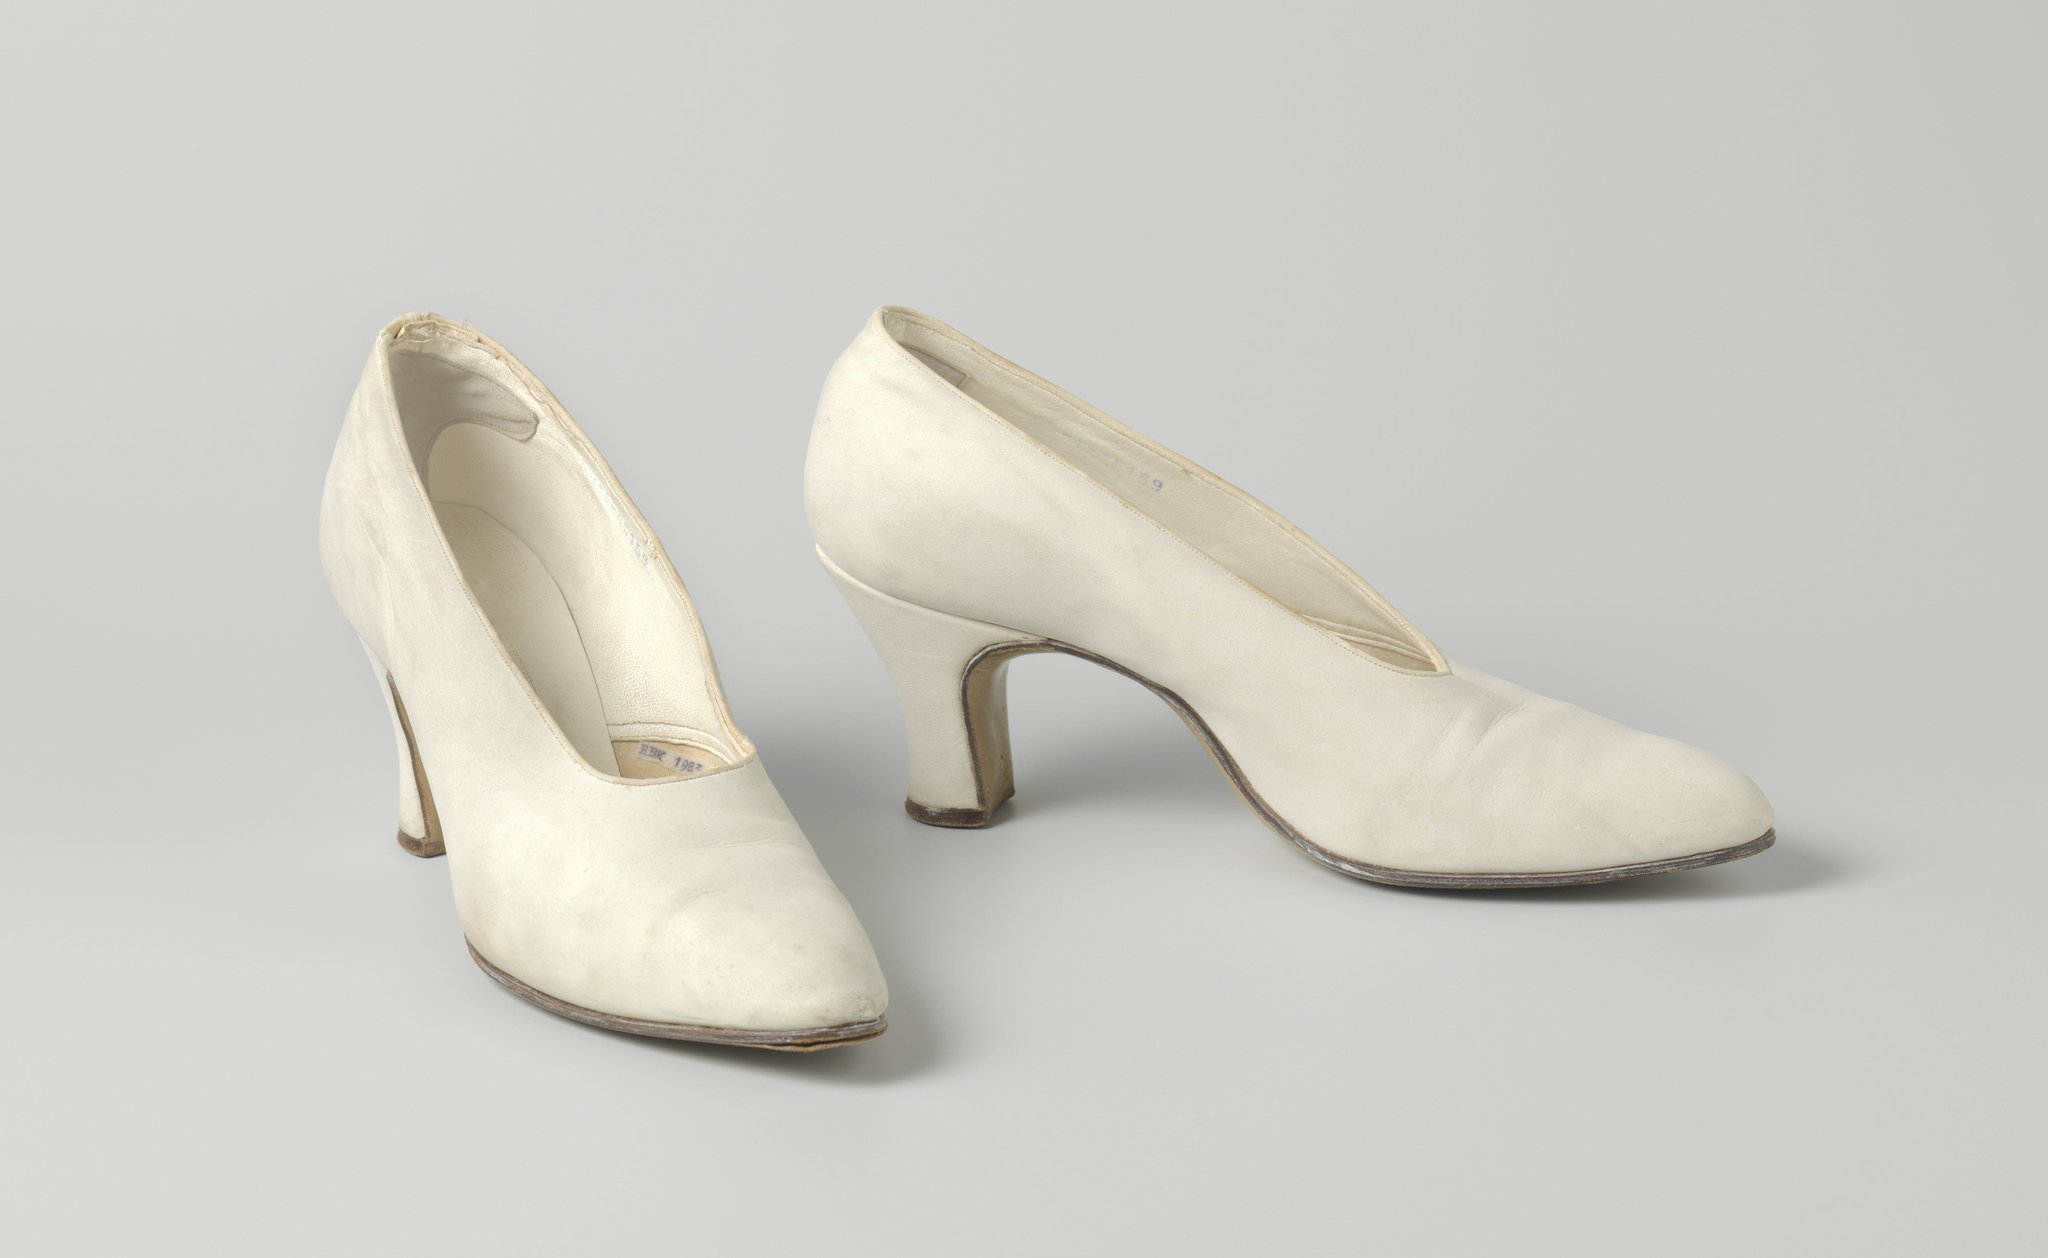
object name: damesschoen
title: Damesschoen van ivoorwit suède, hoog uitgesneden schachtrand en hoge hak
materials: leather, linen, metal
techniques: tanning, weave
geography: amsterdam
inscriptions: company name: ‘HIRSCH & Cie // AMSTERDAM’, inscription: ‘5½ - 4 - 45159’, size: ‘5½ // 4’, company name: ‘HIRSCH & Cie // AMSTERDAM’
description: Damesschoen van ivoorwit suède. Model: Spitse neus, blad uit één stuk leer. De voorkant van de hak loopt in een afgeronde hoek recht naar beneden. De zijkant en achterkant zijn iets getailleerd en bekleed met ivoorwit suède. De hak heeft een donkerbruine rand leer van het achterlapje. Leren achterlapje met zes spijkers aan de hak vastgeslagen en leren zool. Vanaf halverwege het geleng naar de hiel is het blad gevoerd met ivoorwit leer. Voorvoet gevoerd met crèmekleurig linnen. In de hiel een stuk grijs geruwd leer in een T-vorm. De binnenzool is van ivoorwit leer. De schachtrand is afgebiesd met ivoorwit ripsband.